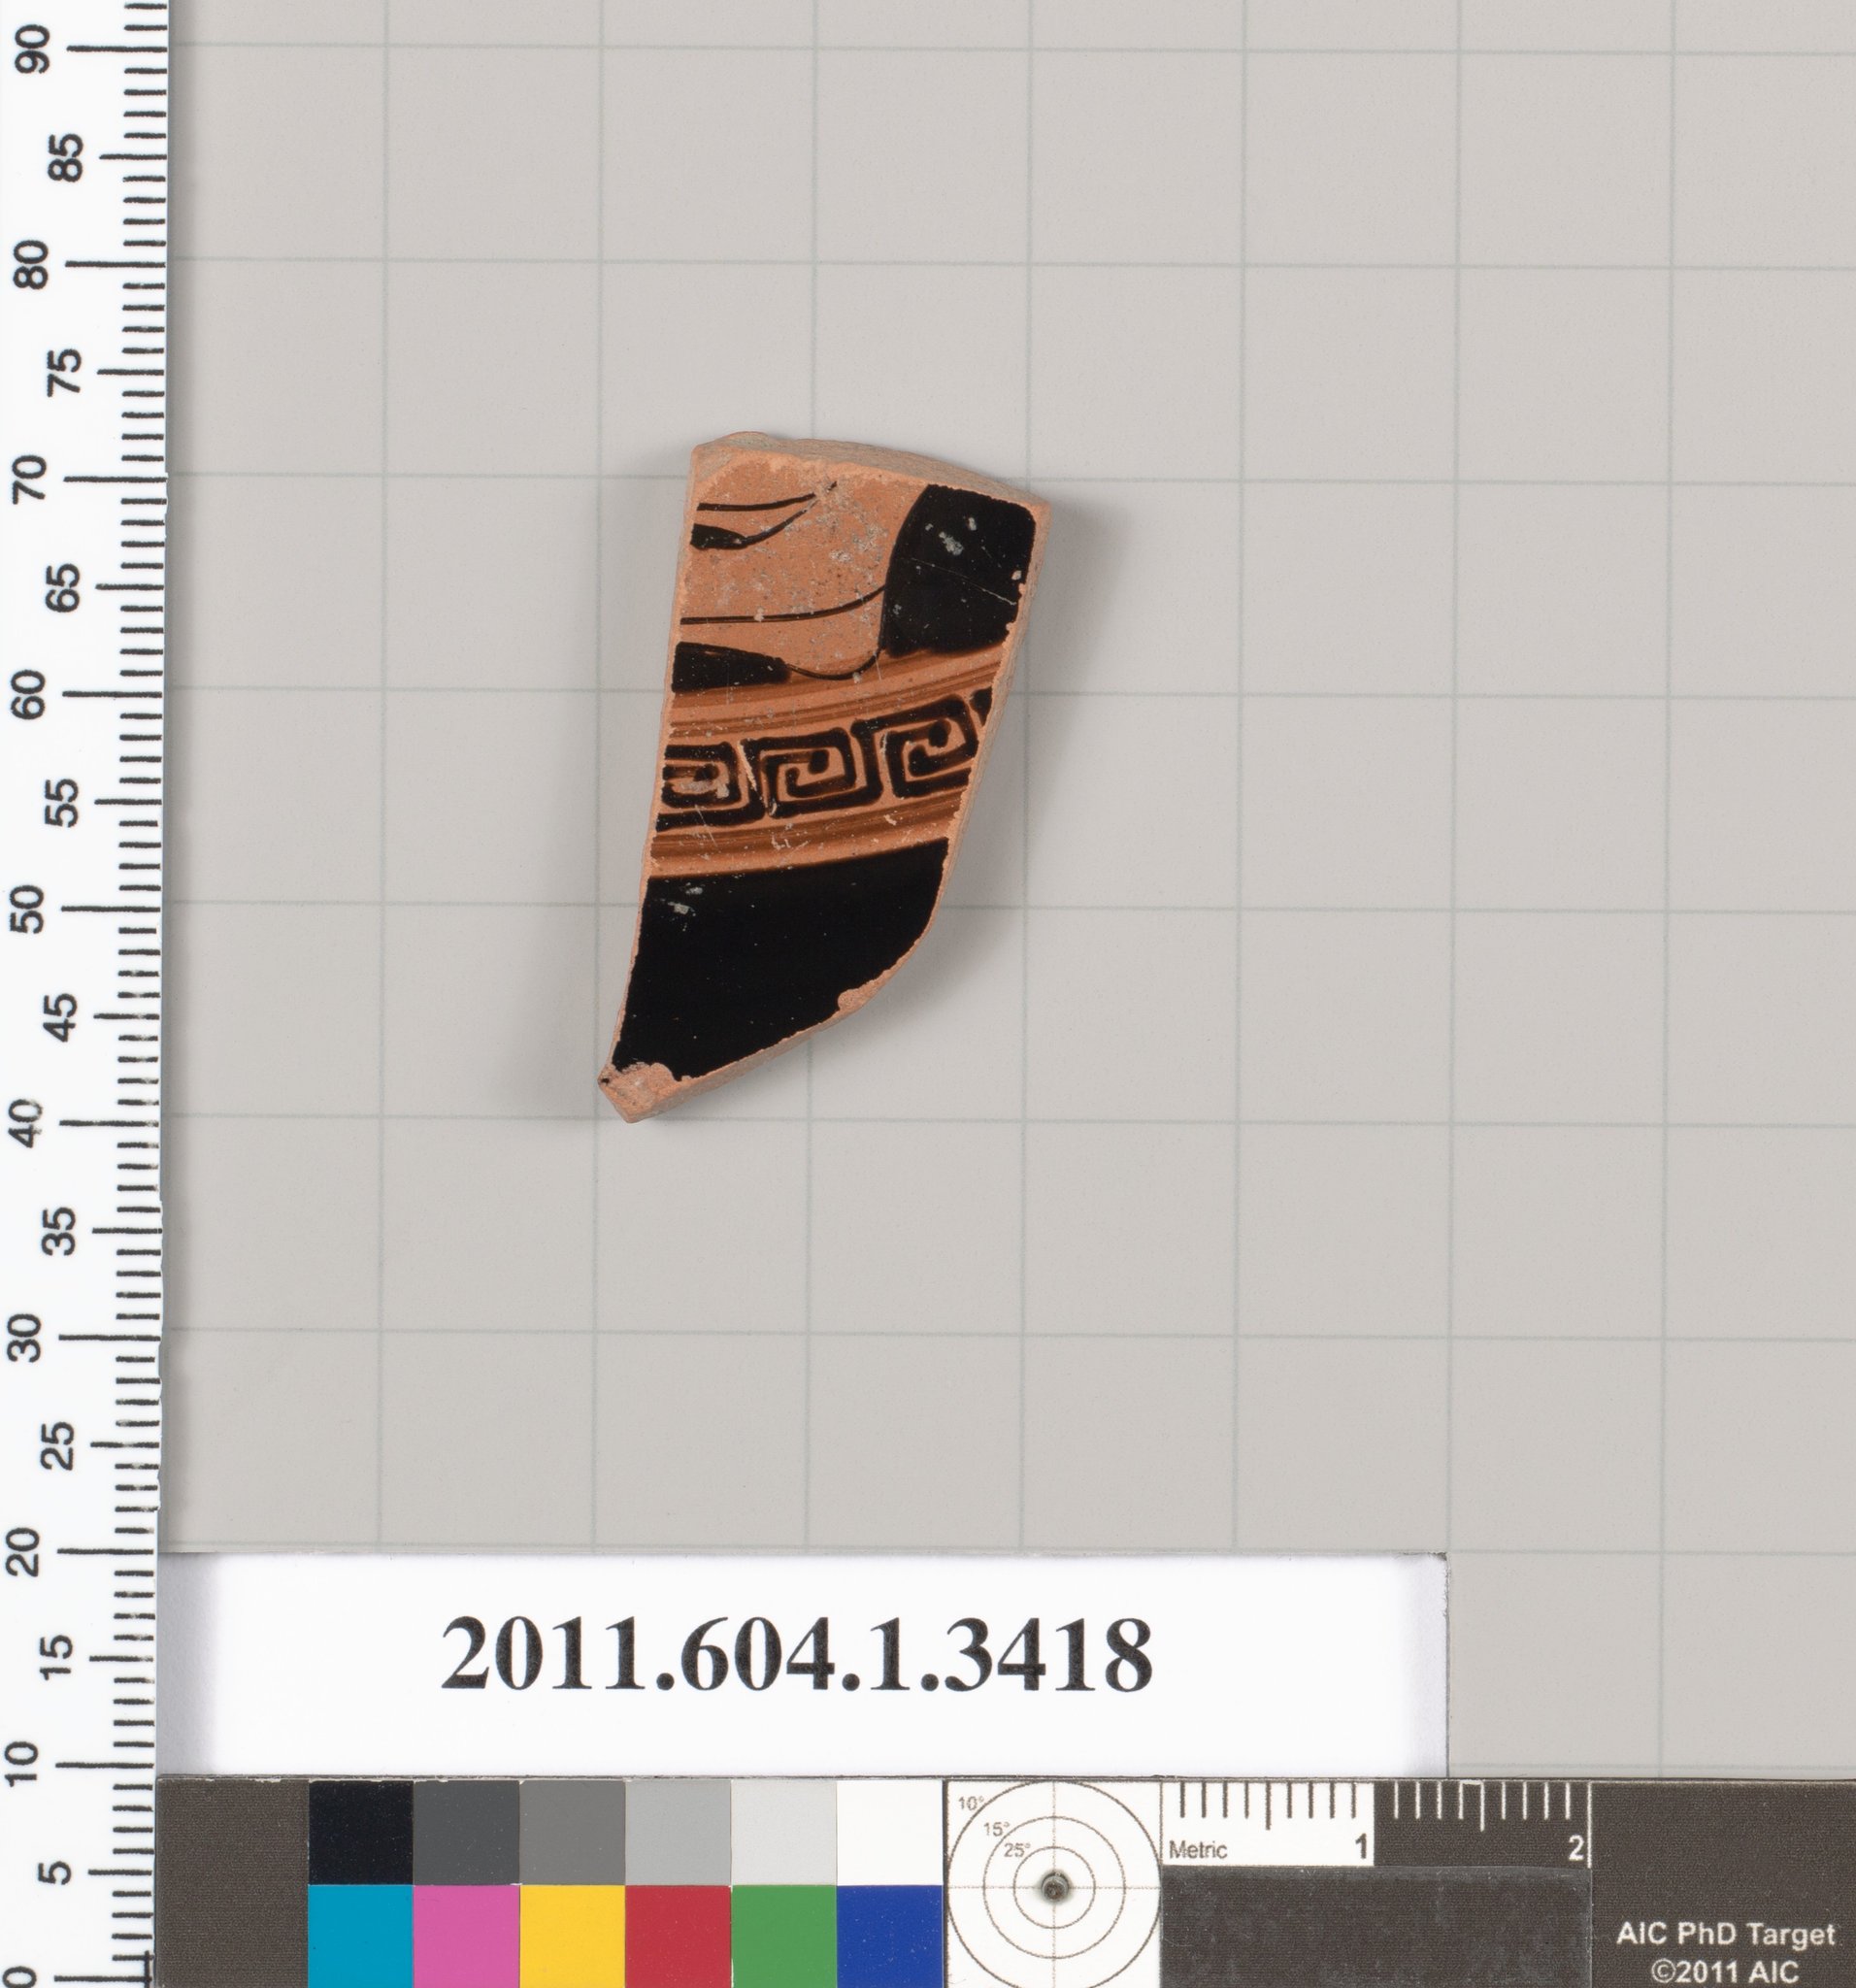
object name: kylix fragment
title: Terracotta fragment of a kylix (drinking cup)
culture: greek, attic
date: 490-470 BCE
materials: terracotta